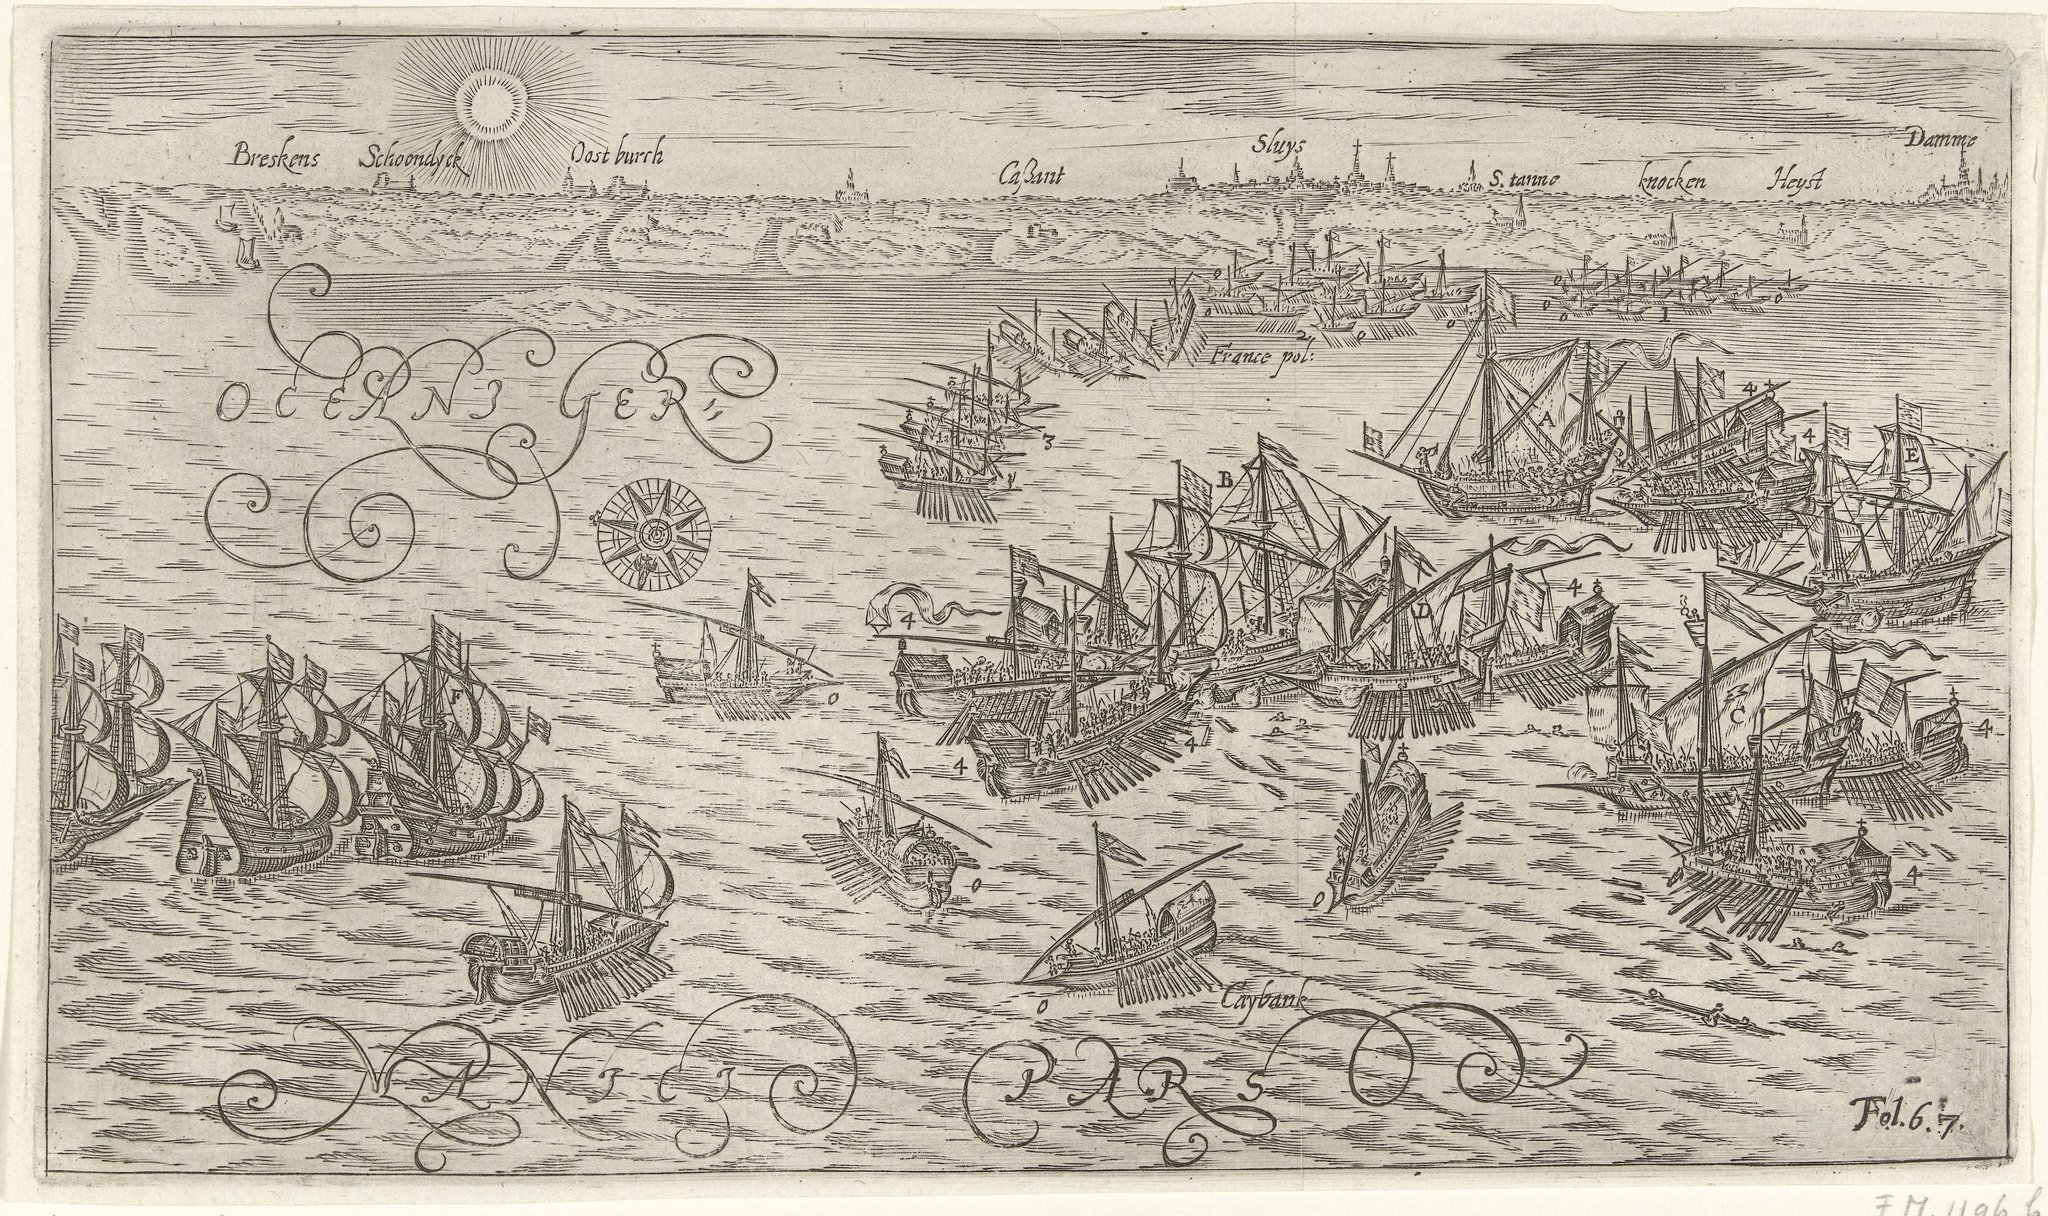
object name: print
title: Zeeslag waarbij de acht galeien van Spinola worden verslagen door de vloot van Joos de Moor, 1603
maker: Anonymous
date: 1603-1613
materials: paper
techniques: engraving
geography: northern netherlands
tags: battle (+ naval force), warfare; military affairs (+ oared ships, e.g.: galley), trireme, galley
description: Waarschijnlijk eerst gebruikt als illustratie in: H. van Haestens, De bloedige ende strenge belegeringhe der stadt Oostende, in Vlaenderen, Leiden 1613. Volgens Muller eerst gebruikt in een Nederlandse editie van 1606 (deze editie niet getraceerd) en in deze staat wellicht afkomstig uit de Franse editie van 1615 getiteld: La nouvelle Troye ou Memorable histoire du siege d'Ostende, of uit een latere onbekende editie.